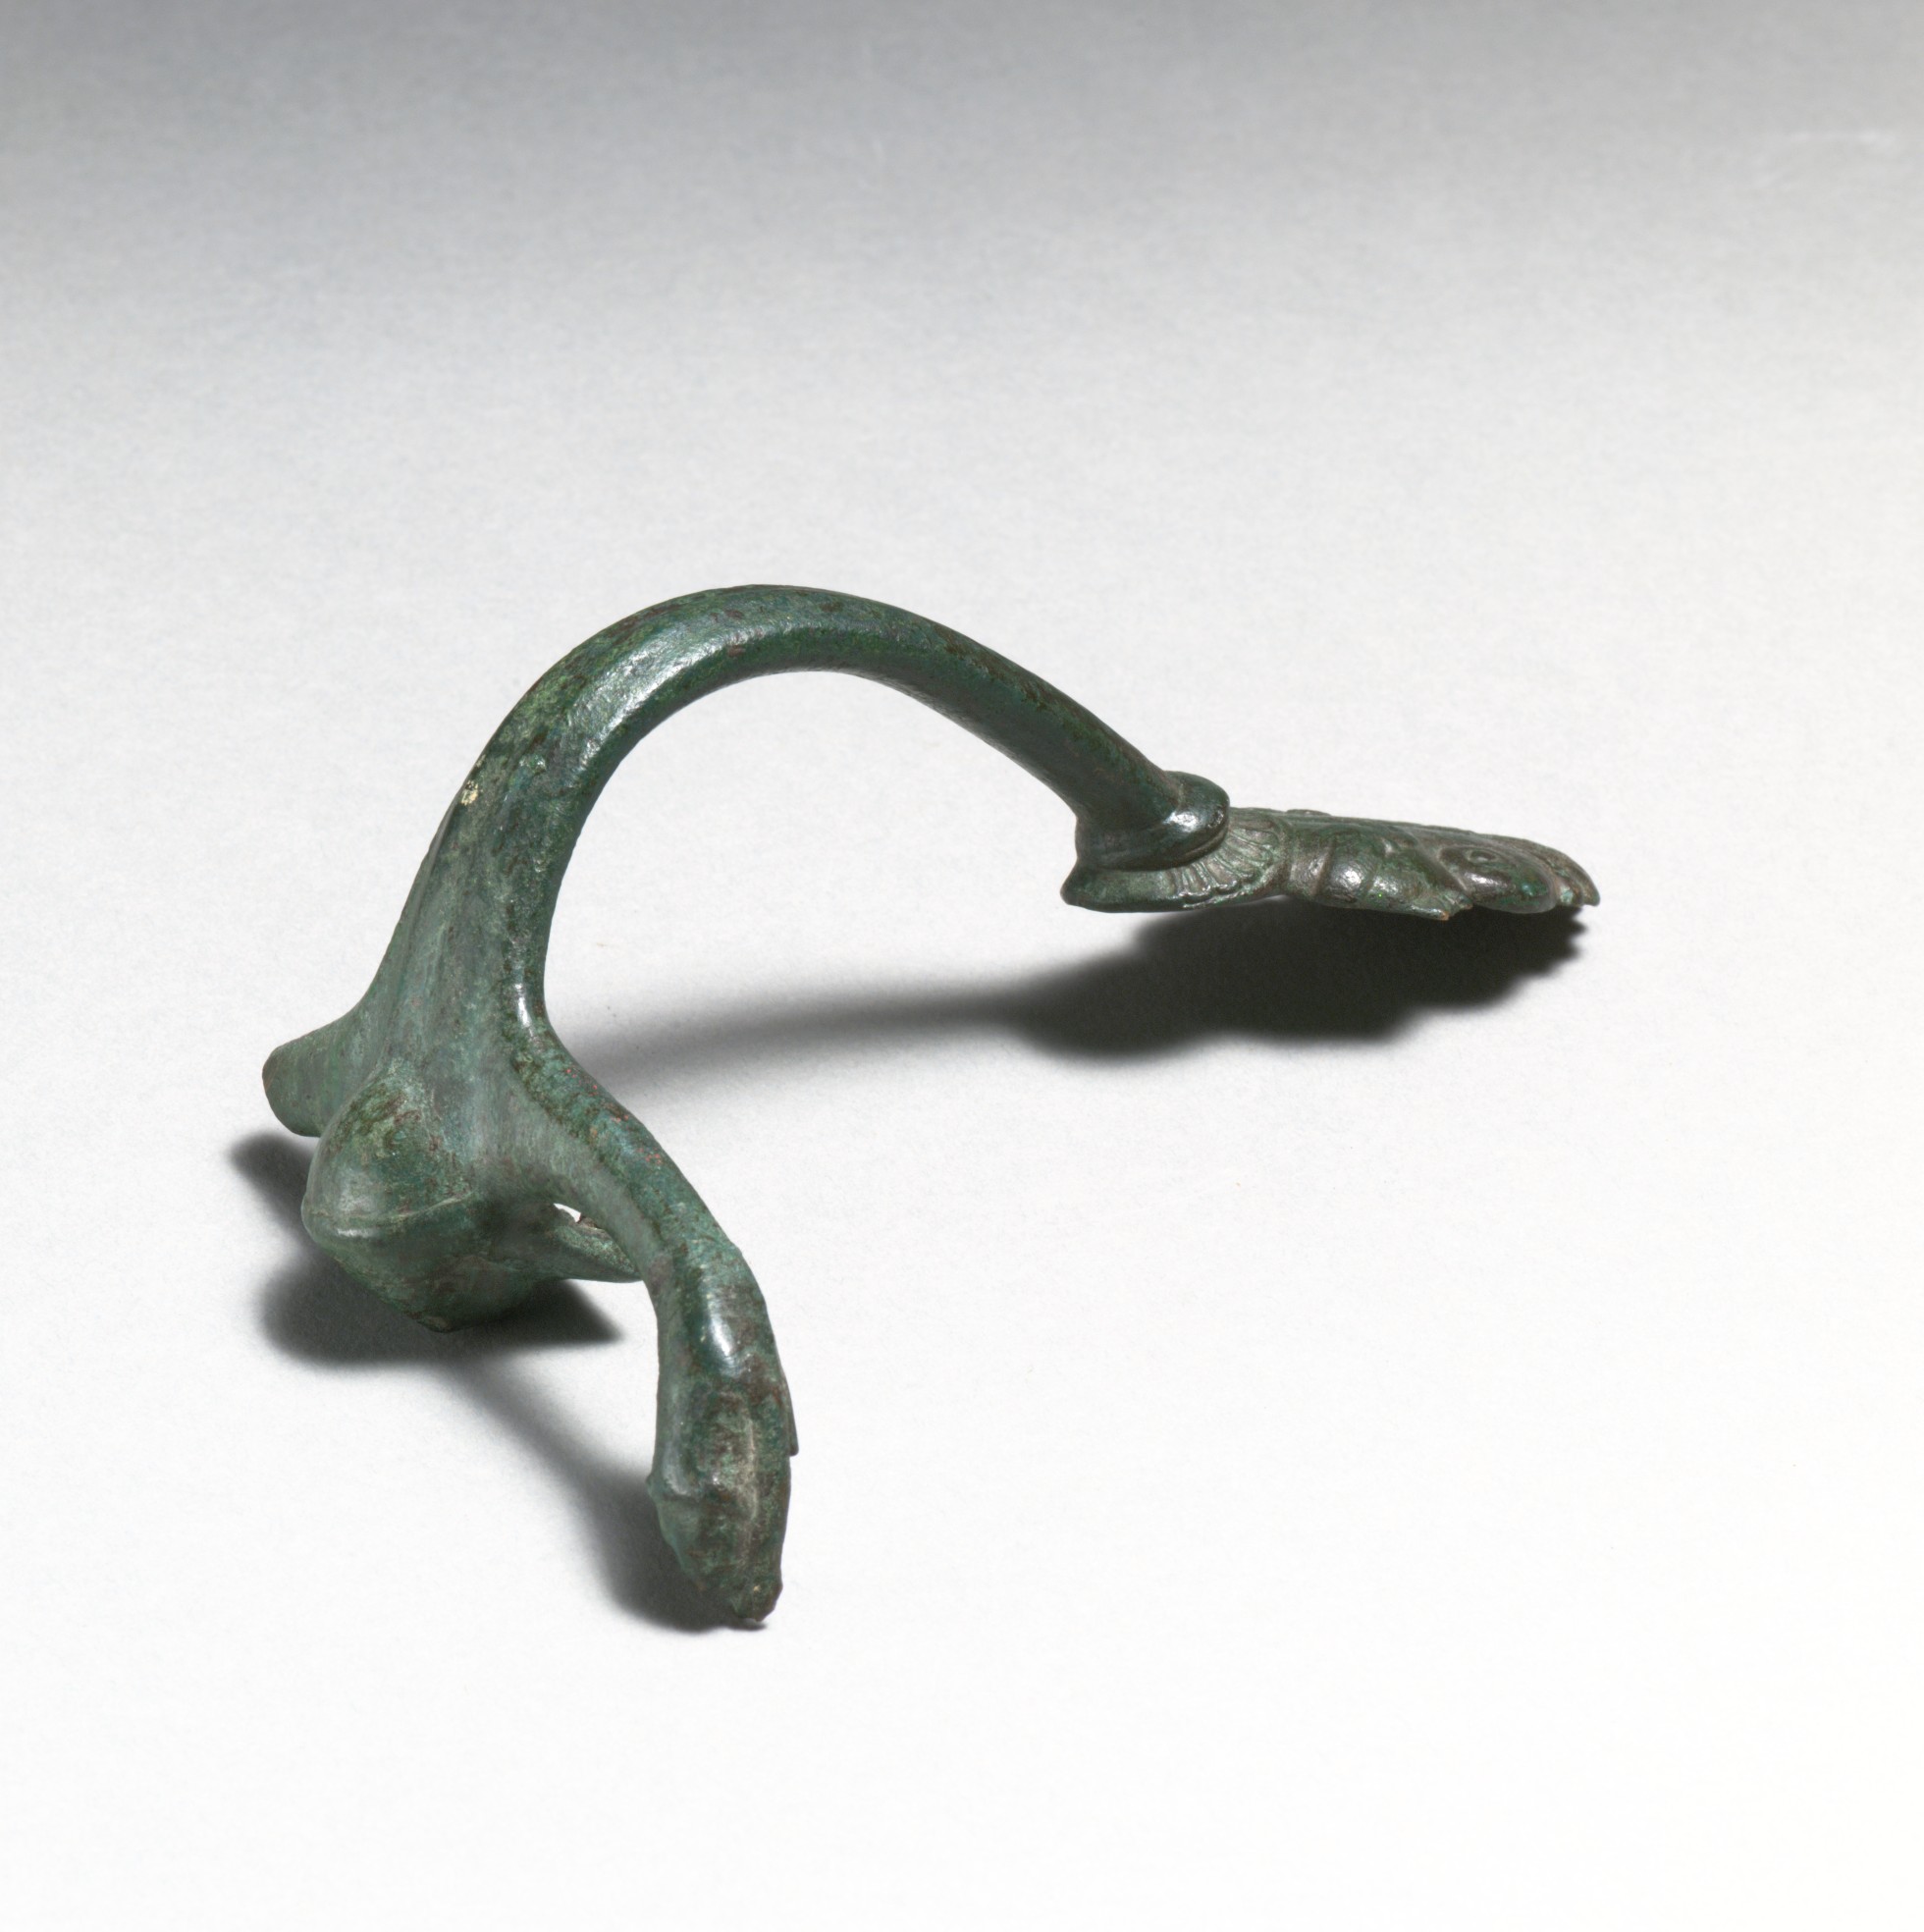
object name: handle with 3 head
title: Bronze handle of a vessel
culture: etruscan or greek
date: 550-490 BCE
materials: bronze